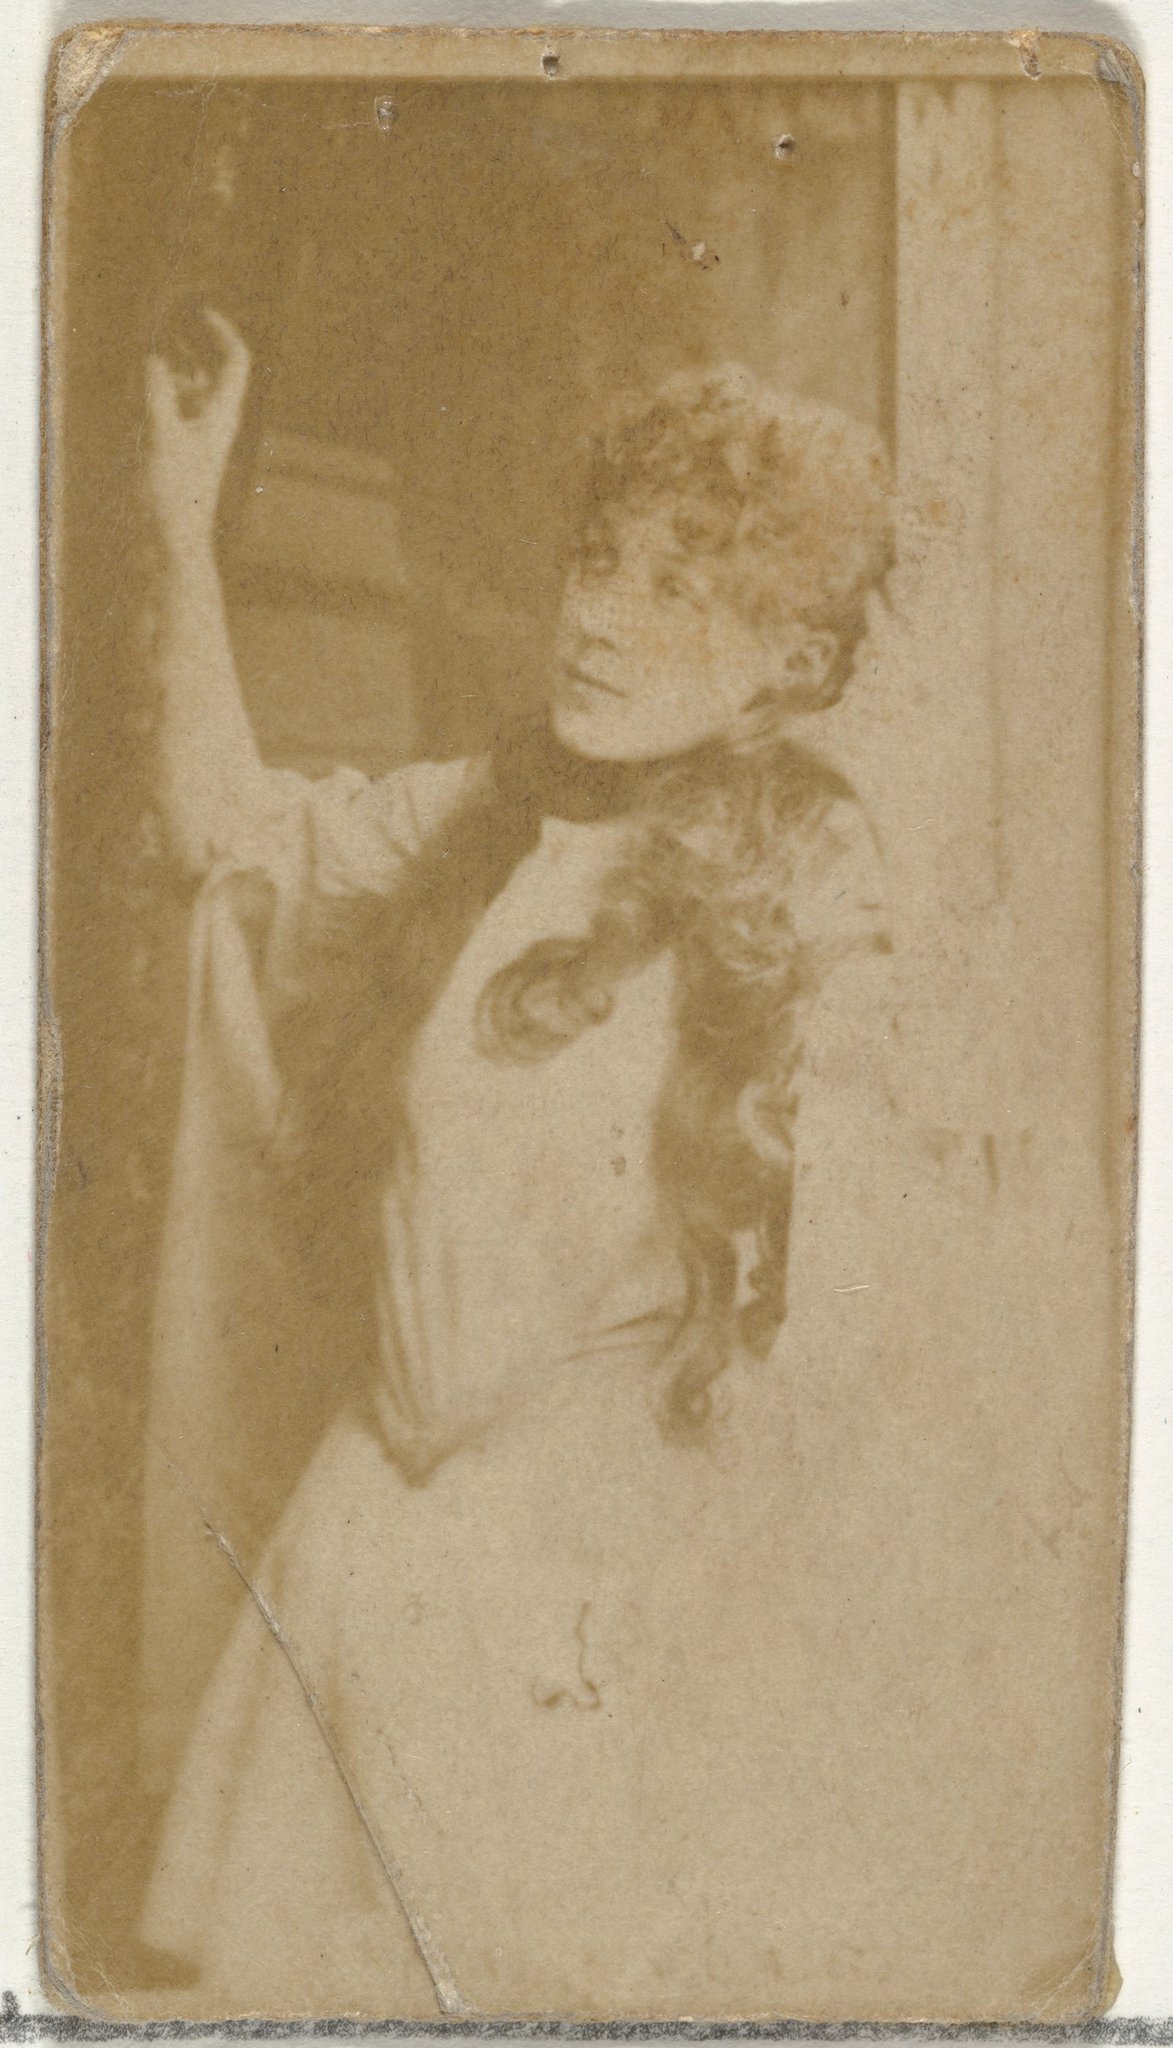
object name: photograph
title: [Actress standing in doorway], from the Actors and Actresses series (N145-8) issued by Duke Sons & Co. to promote Duke Cigarettes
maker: w. duke, sons & co.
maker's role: publisher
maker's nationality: american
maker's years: 1870-1920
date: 1891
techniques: albumen silver print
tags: portraits,women,actresses